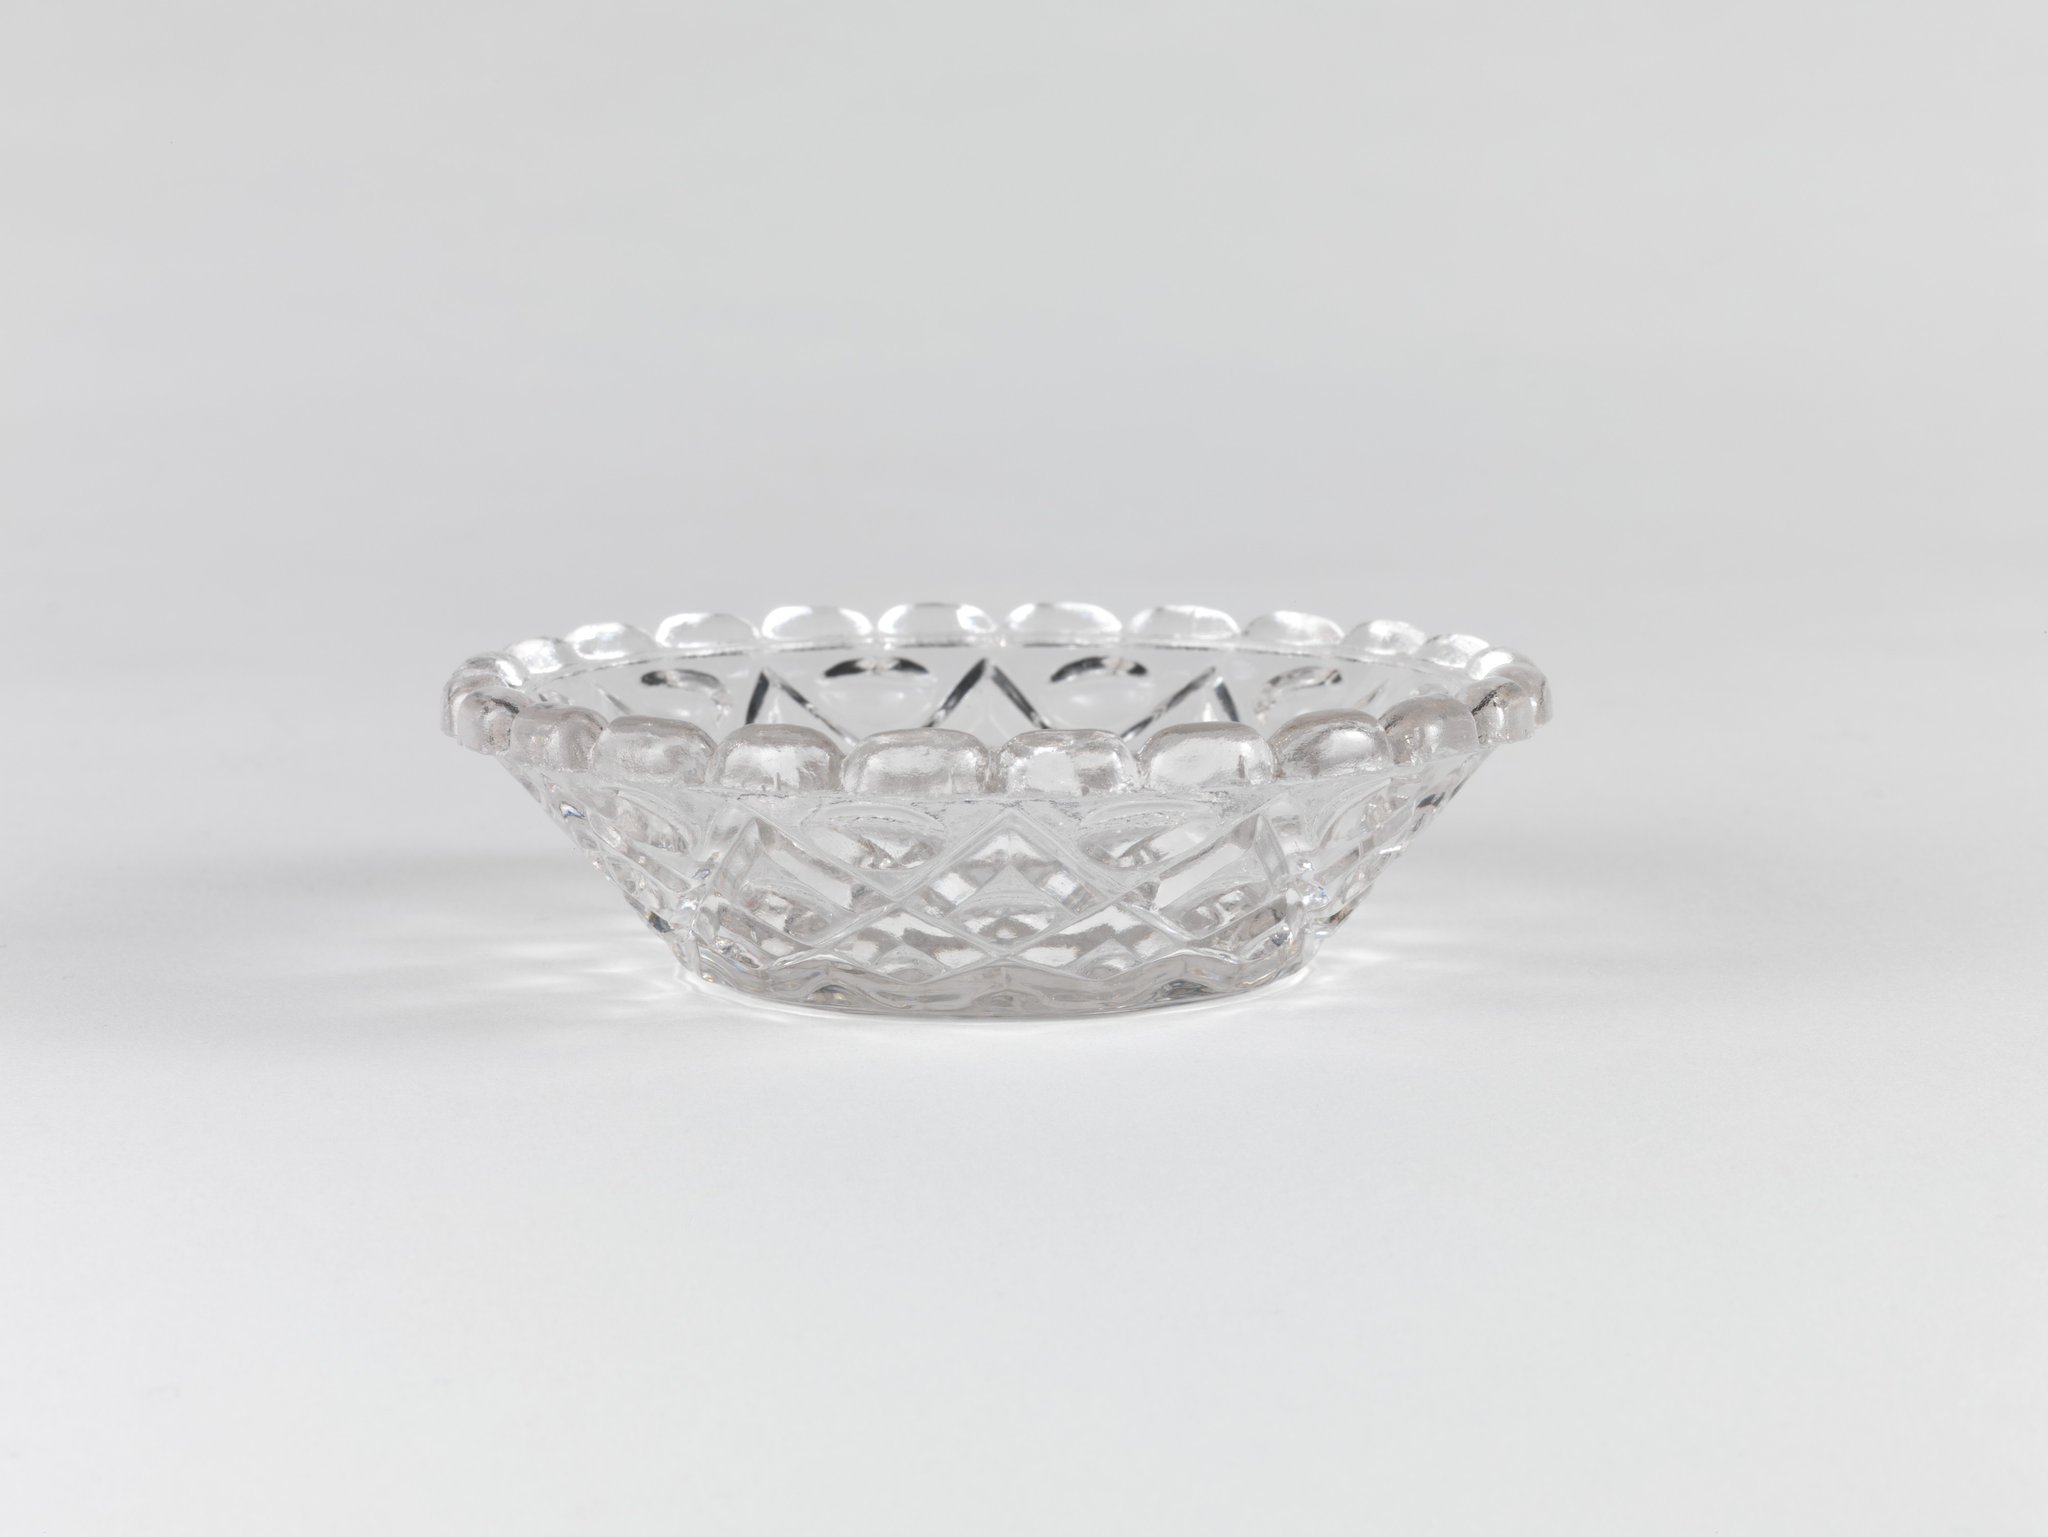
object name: honey dish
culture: american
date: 1850-1860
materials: diamond, glass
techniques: pressed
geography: united states